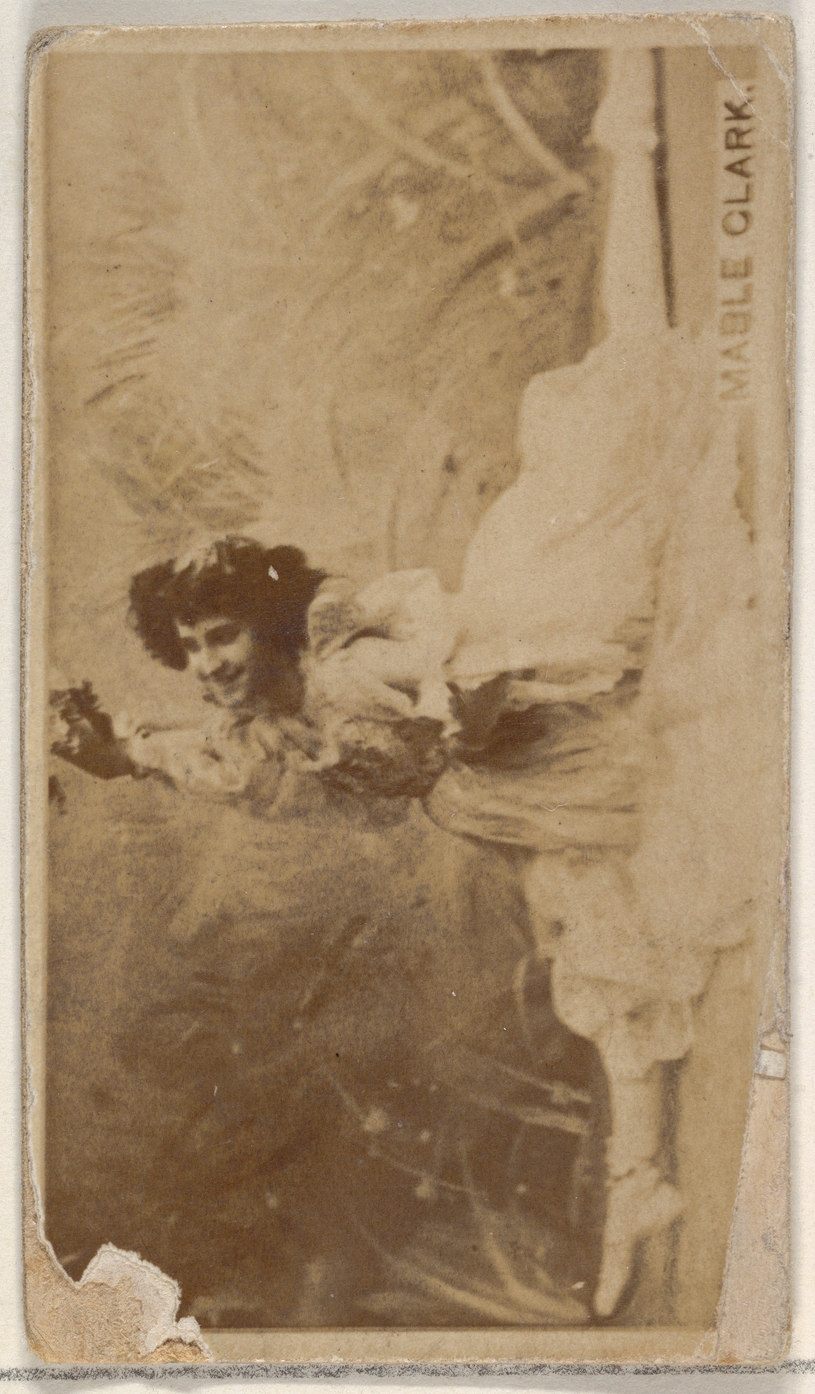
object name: photograph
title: Mabel Clark, from the Actors and Actresses series (N45, Type 8) for Virginia Brights Cigarettes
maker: allen & ginter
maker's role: publisher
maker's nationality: american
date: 1888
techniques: albumen silver print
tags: portraits,women,actresses